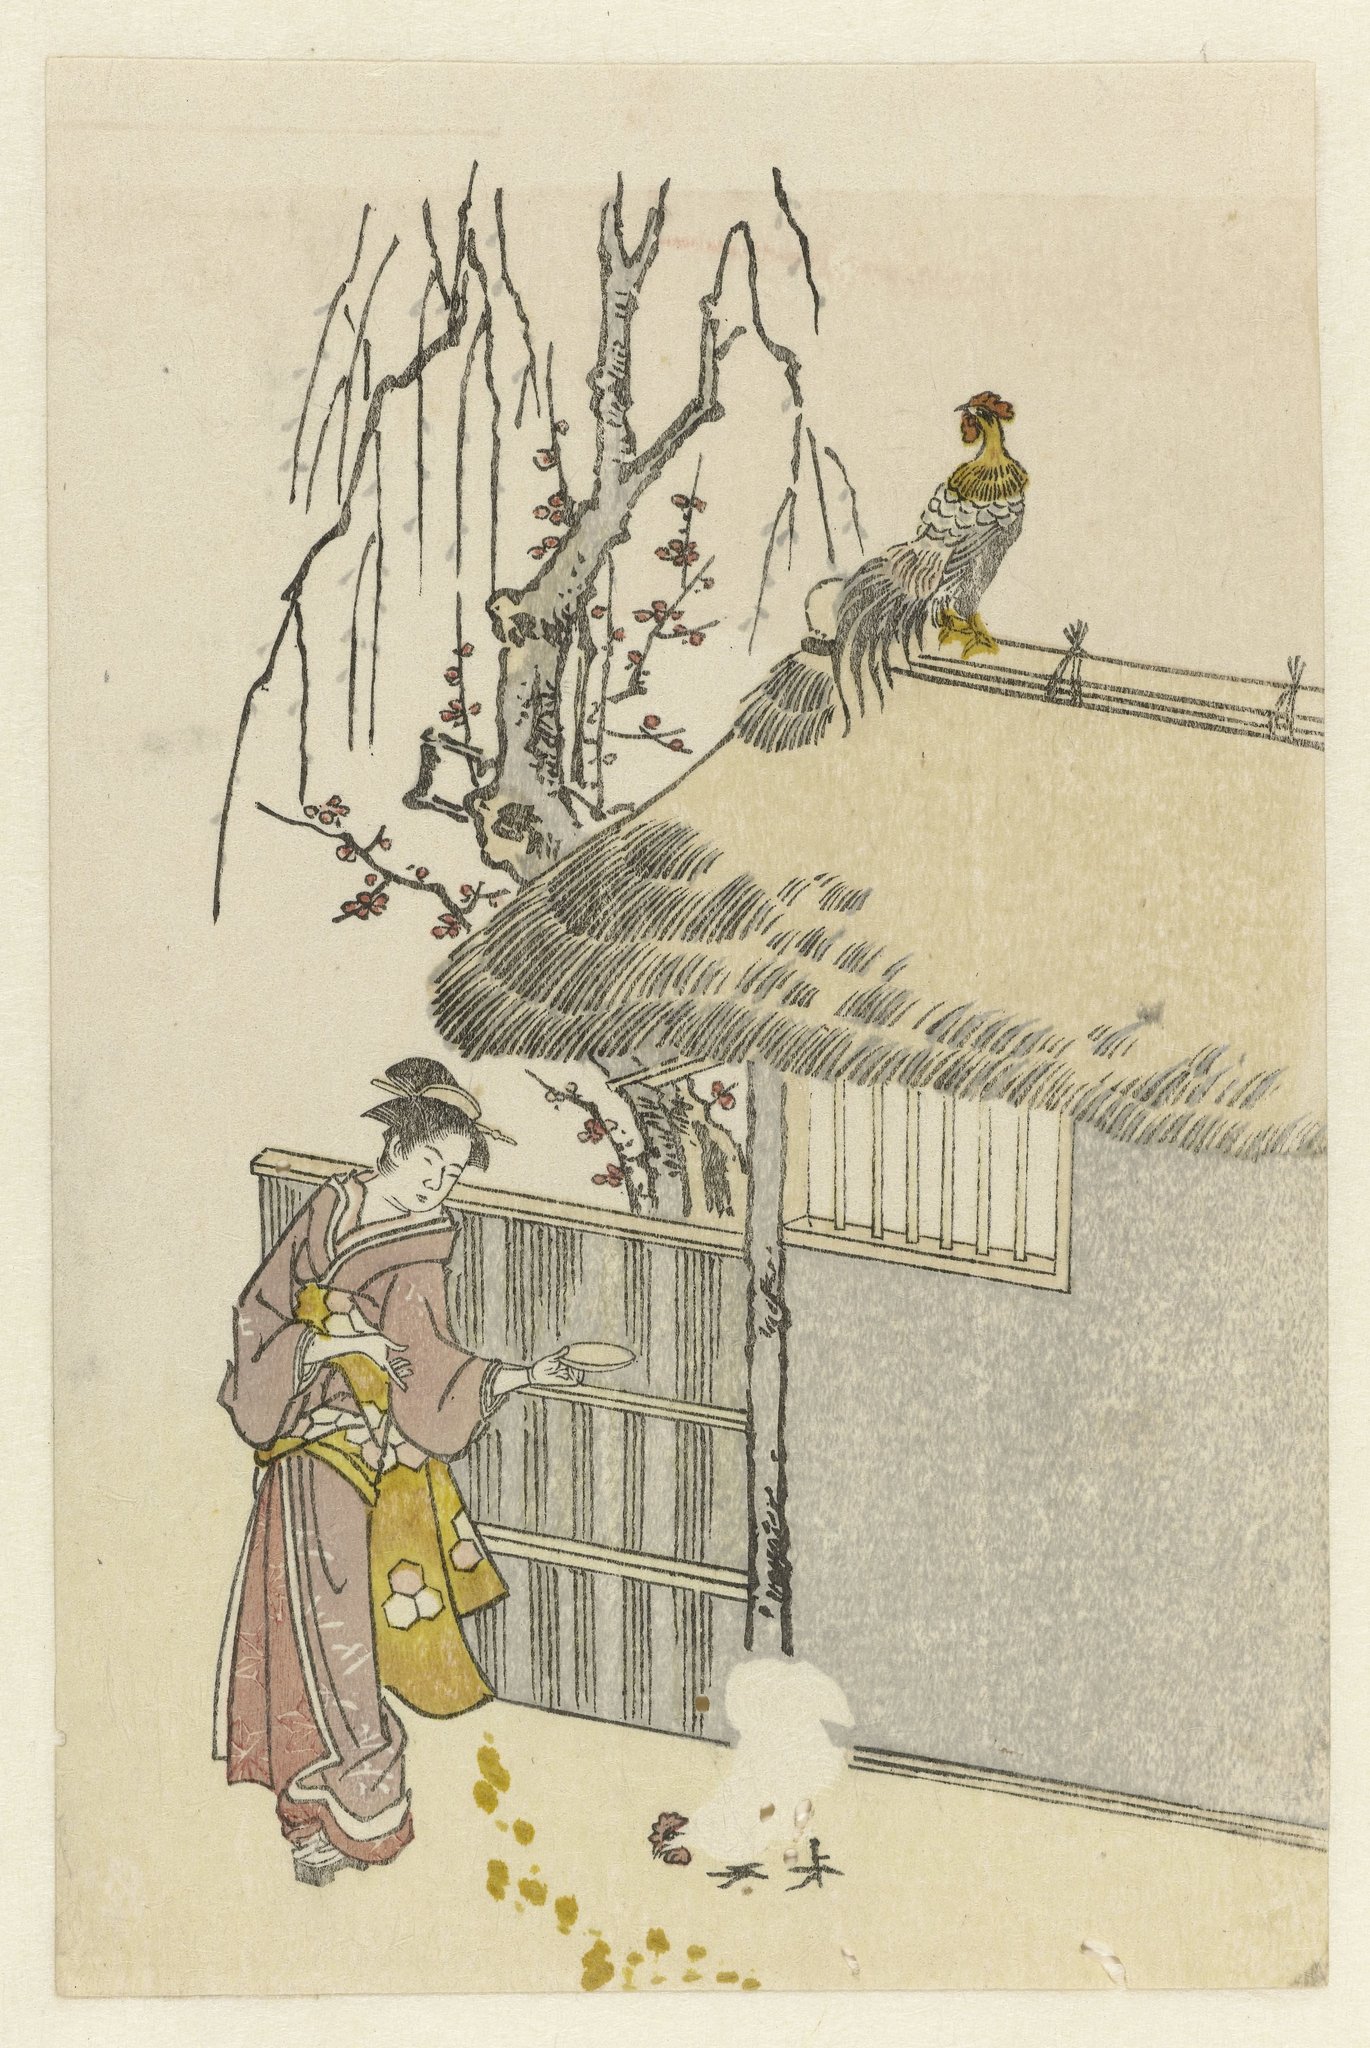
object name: print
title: Egoyomi voor het jaar van de haan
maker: Anonymous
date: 1789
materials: paper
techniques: blind stamped, woodcut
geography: japan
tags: adult woman, housing, fowl (cock, hen, chicken, etc.)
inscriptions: collector's mark, verso, stamped: Lugt 2228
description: Naast een huisje staat een vrouw die een witte haan voert. Op haar rok de nummers van de korte maanden. Op de nok van het huisje een gekleurde haan.